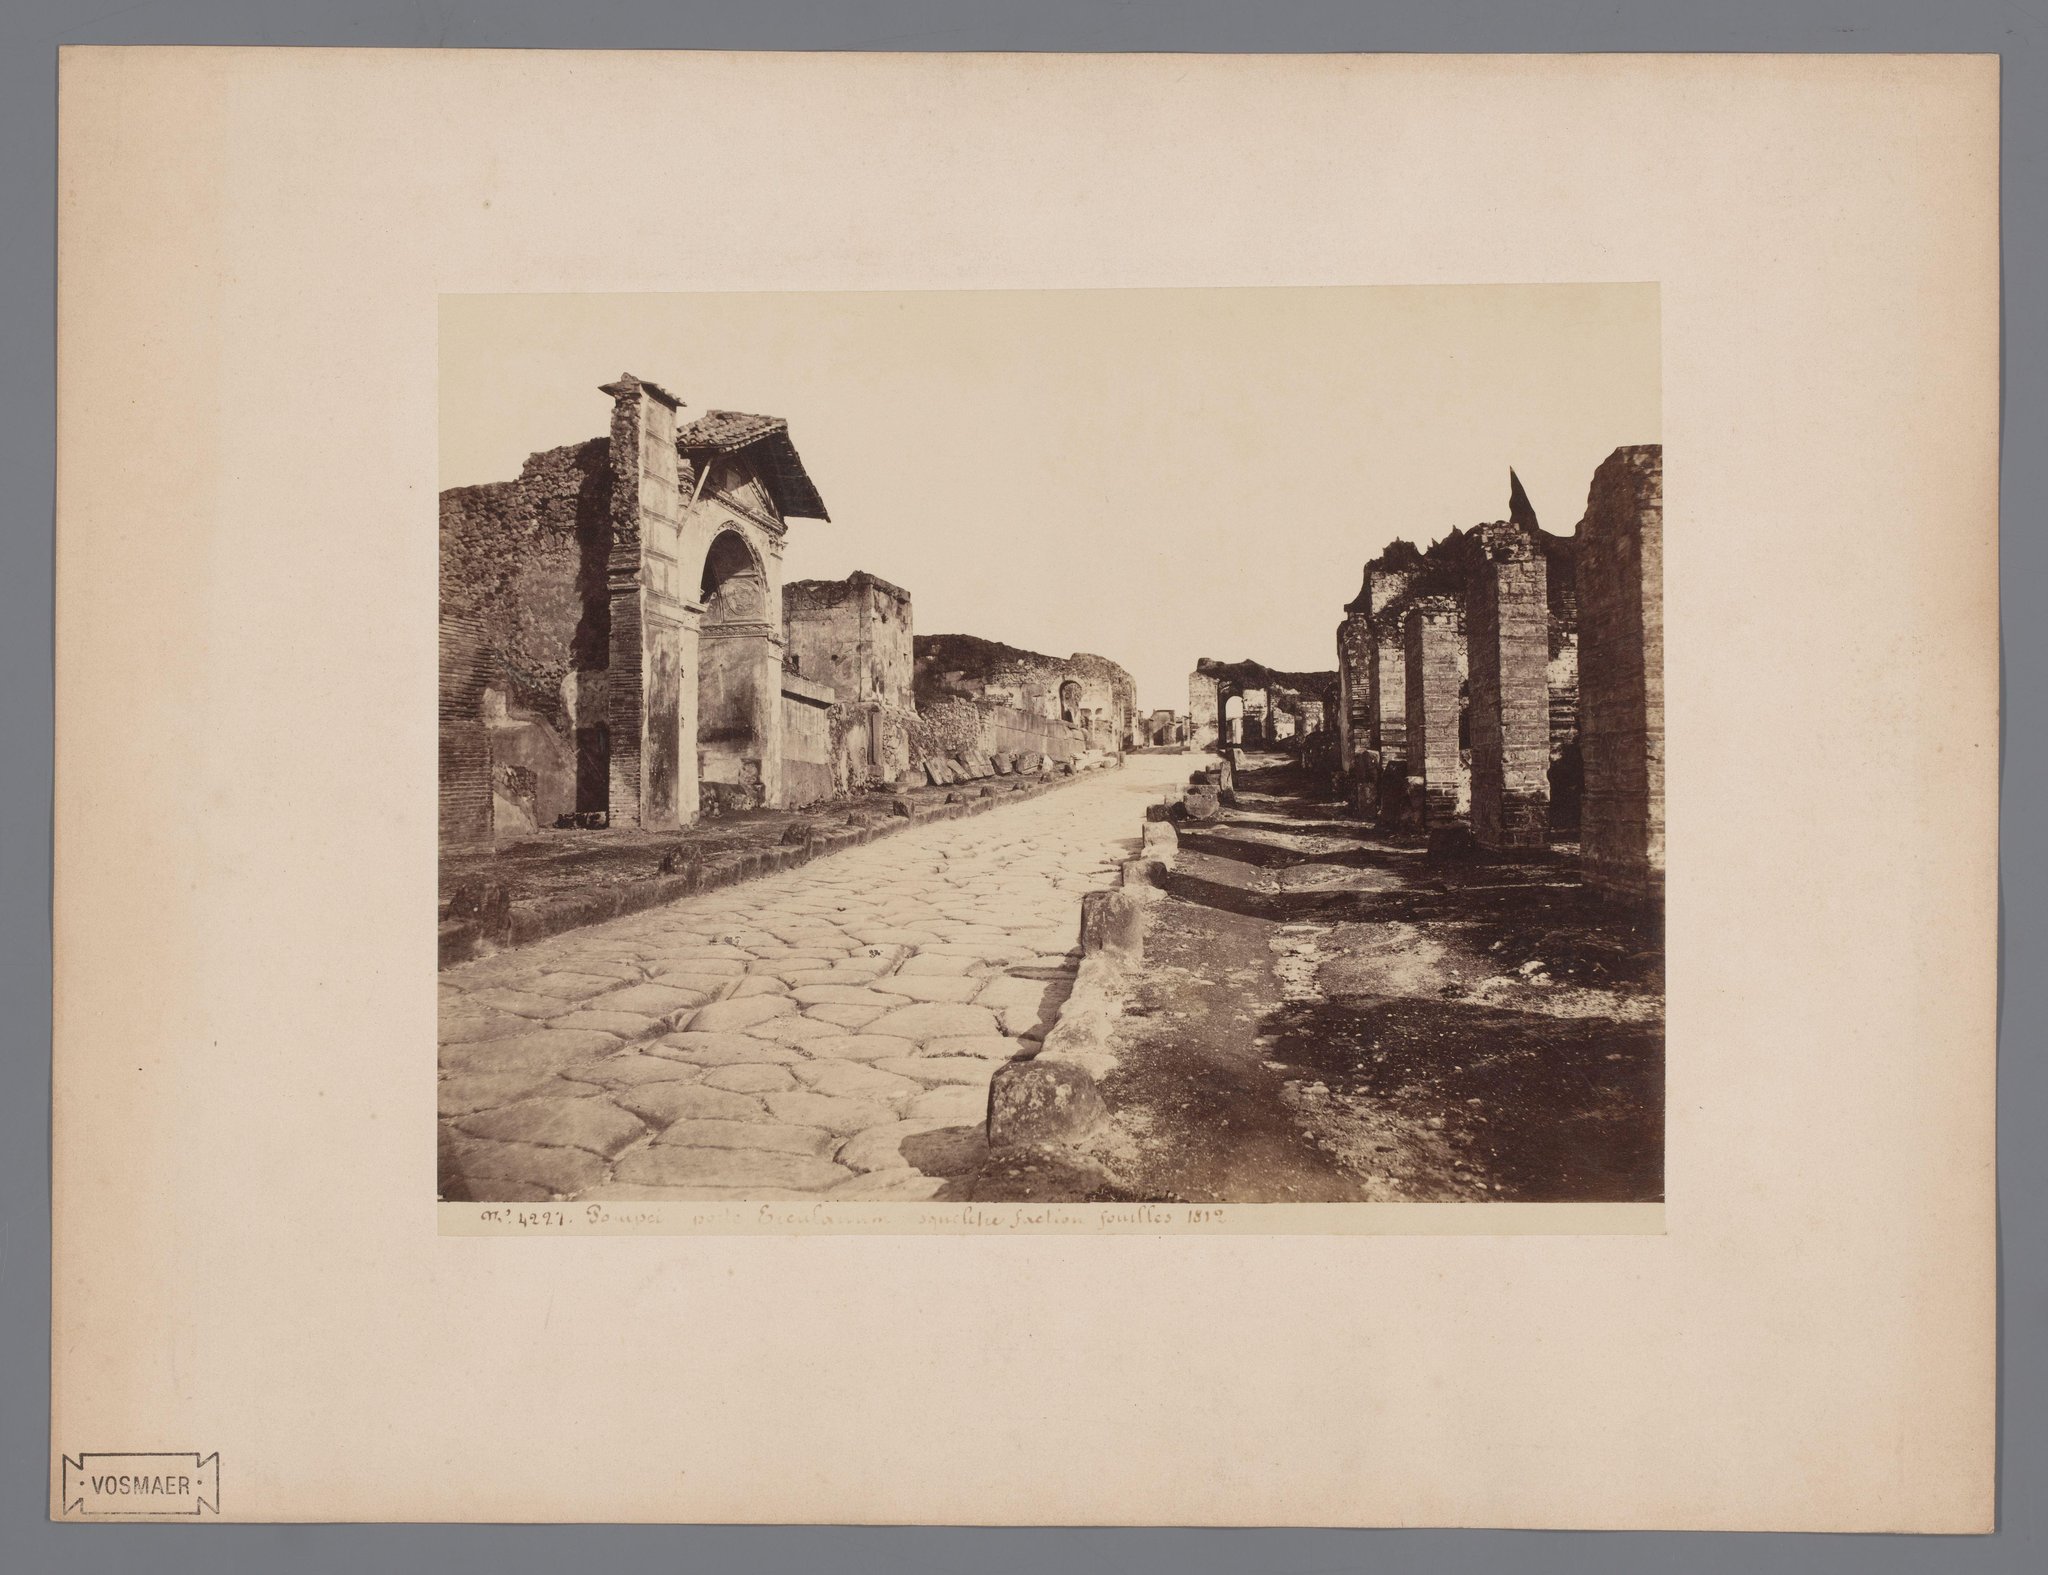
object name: photograph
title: Porte Erculaneum faction fouillés 1812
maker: giorgio sommer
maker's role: fotograaf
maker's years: 1834-1914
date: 1857-1875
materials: cardboard, paper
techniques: albumen print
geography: pompeii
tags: ruin of a building ~ architecture, landscape with ruins, gate, entrance, street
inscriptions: collector's mark: ‘VOSMAER’, number: ‘No. 4221’